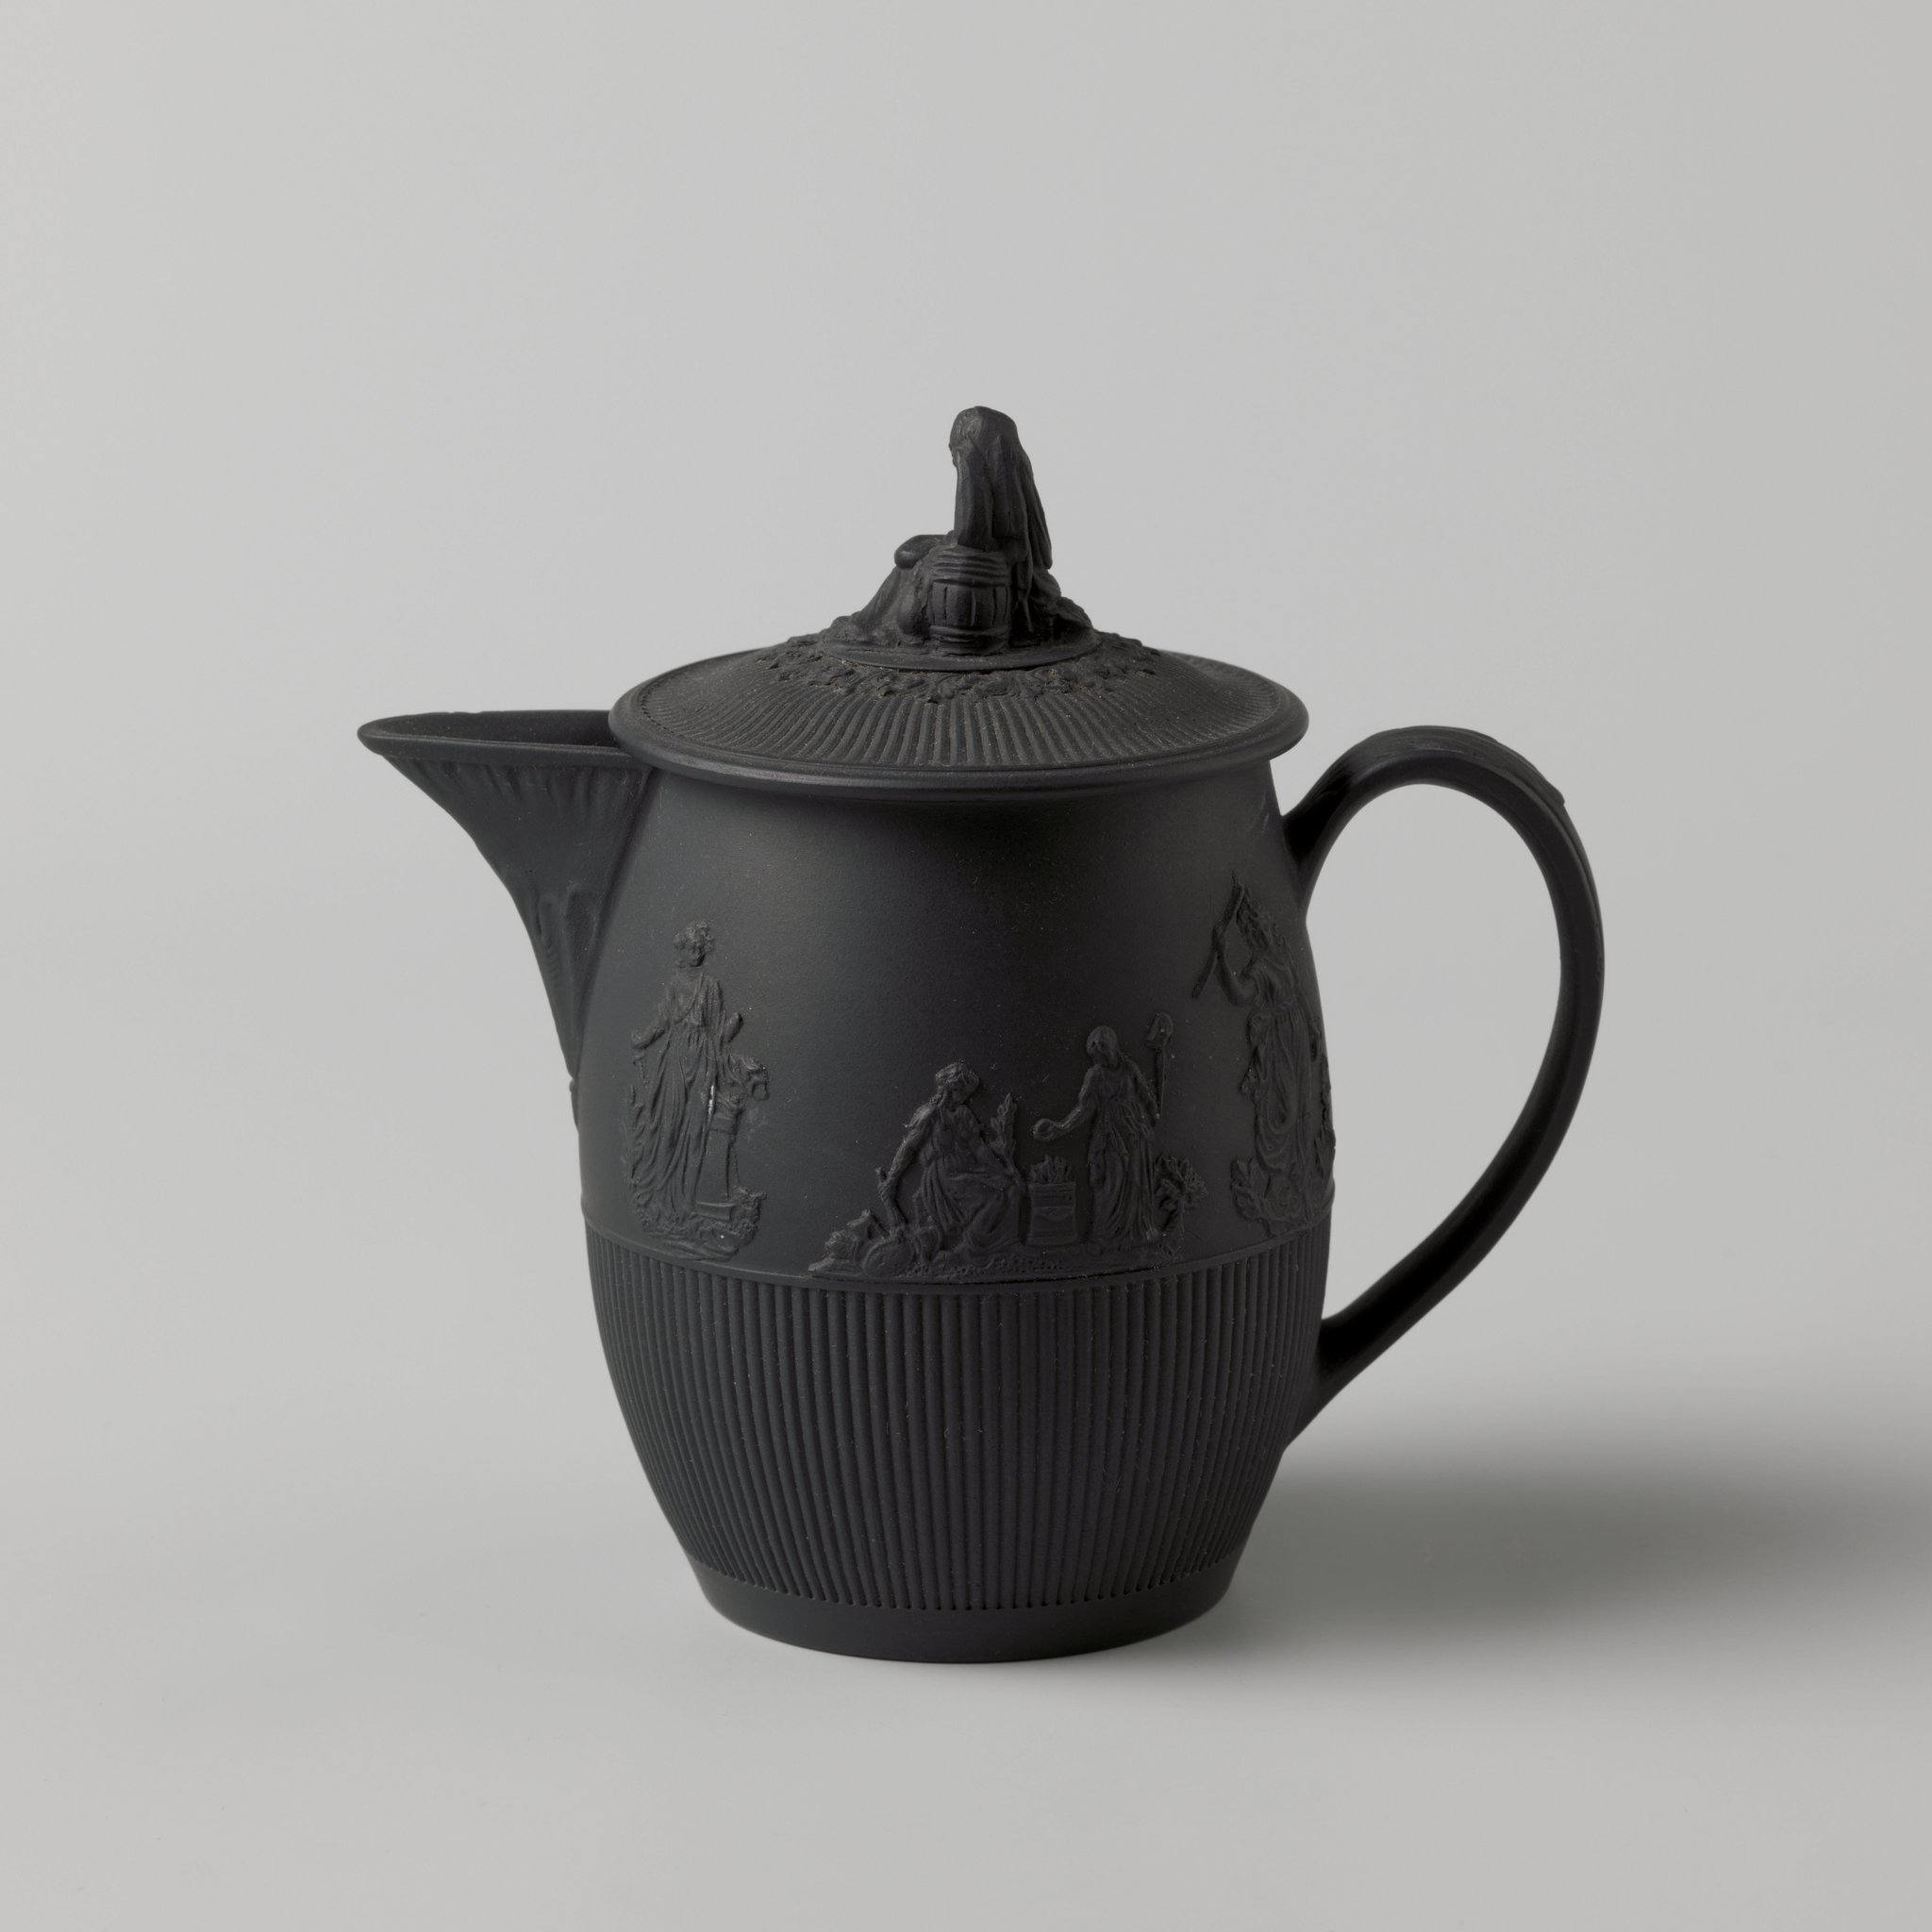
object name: milk jug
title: Melkkan van aardewerk, E.J. Birch Black Basalt. Met deksel.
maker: edmund john birch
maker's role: aardewerkfabriek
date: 1790-1810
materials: earthenware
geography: hanley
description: Convex cilindrische melkkan van aardewerk, Black Basalt. De kan heeft een C-vormig oor, een gebogen sneb en een deksel met een knop in de vorm van een zittende vrouw met haar linkerarm rustend op een vat. De onderste helft van de buik van de kan is geribd en daarboven is een afbeelding in reliëf van allegorische vrouwen en musicerende kinderen. De kan is gemerkt.